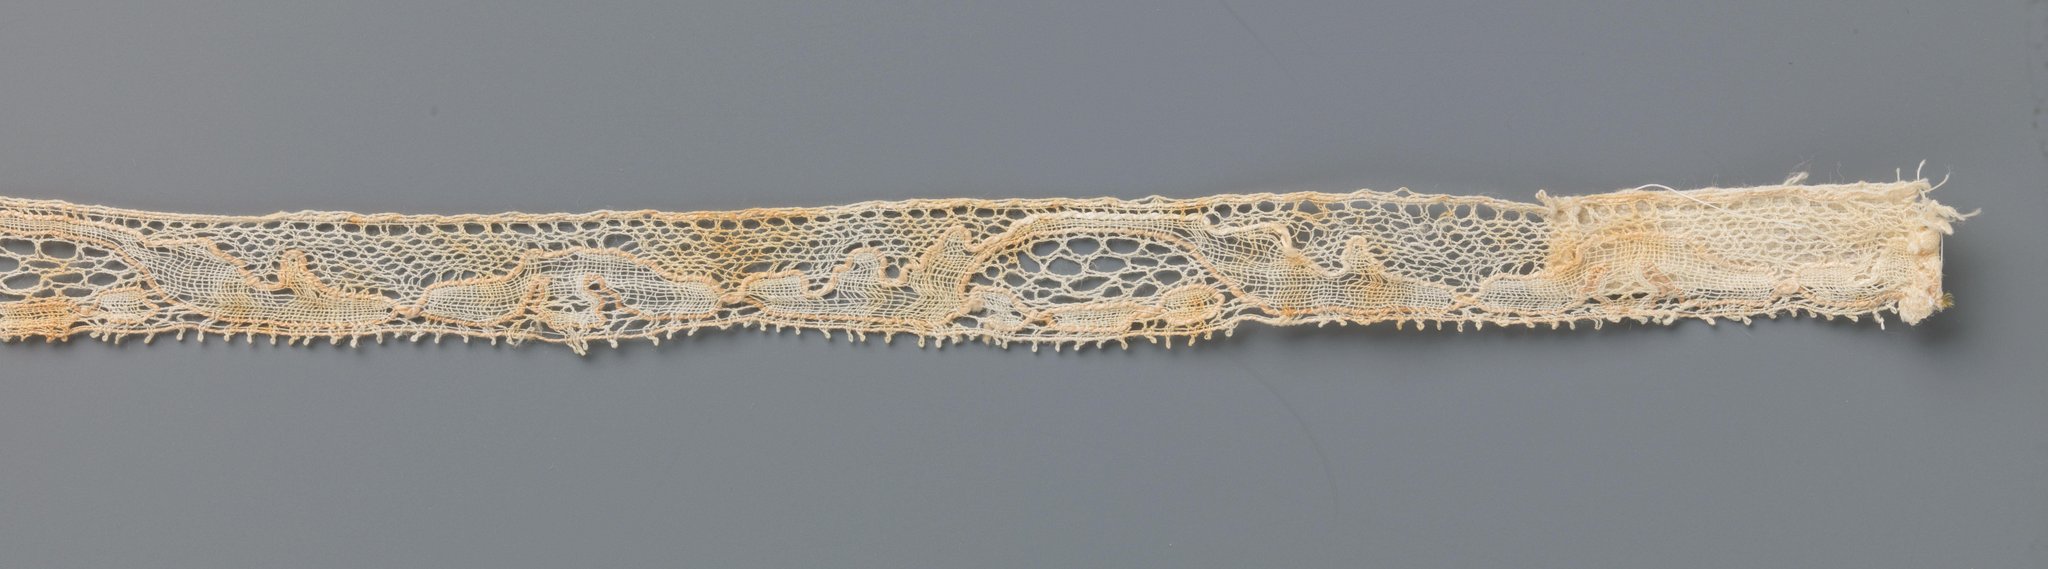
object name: strip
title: Strook kloskant met grillig omlijste cartouche en drielobbig motief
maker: Anonymous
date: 1700-1799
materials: linen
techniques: lace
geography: mechelen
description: Strook naturelkleurige kloskant: Mechelse kant. Het zich herhalende patroon bestaat uit een aaneenschakeling van een trapeziumvormig cartouche met een grillige omlijsting en een grillig langgerekt drielobbig motief. De motieven liggen tegen de onderrand aan en de cartouches vullen bijna de gehele strook tot aan de bovenzijde. Ze zijn met elkaar verbonden door een fijne maasgrond. De motieven zijn gemaakt in linnenslag met dikkere en glimmende contourdraden. Er is een siergrond met grovere mazen toegepast in de cartouches. Boven- en onderzijde zijn recht afgewerkt met langs de onderzijde picots.